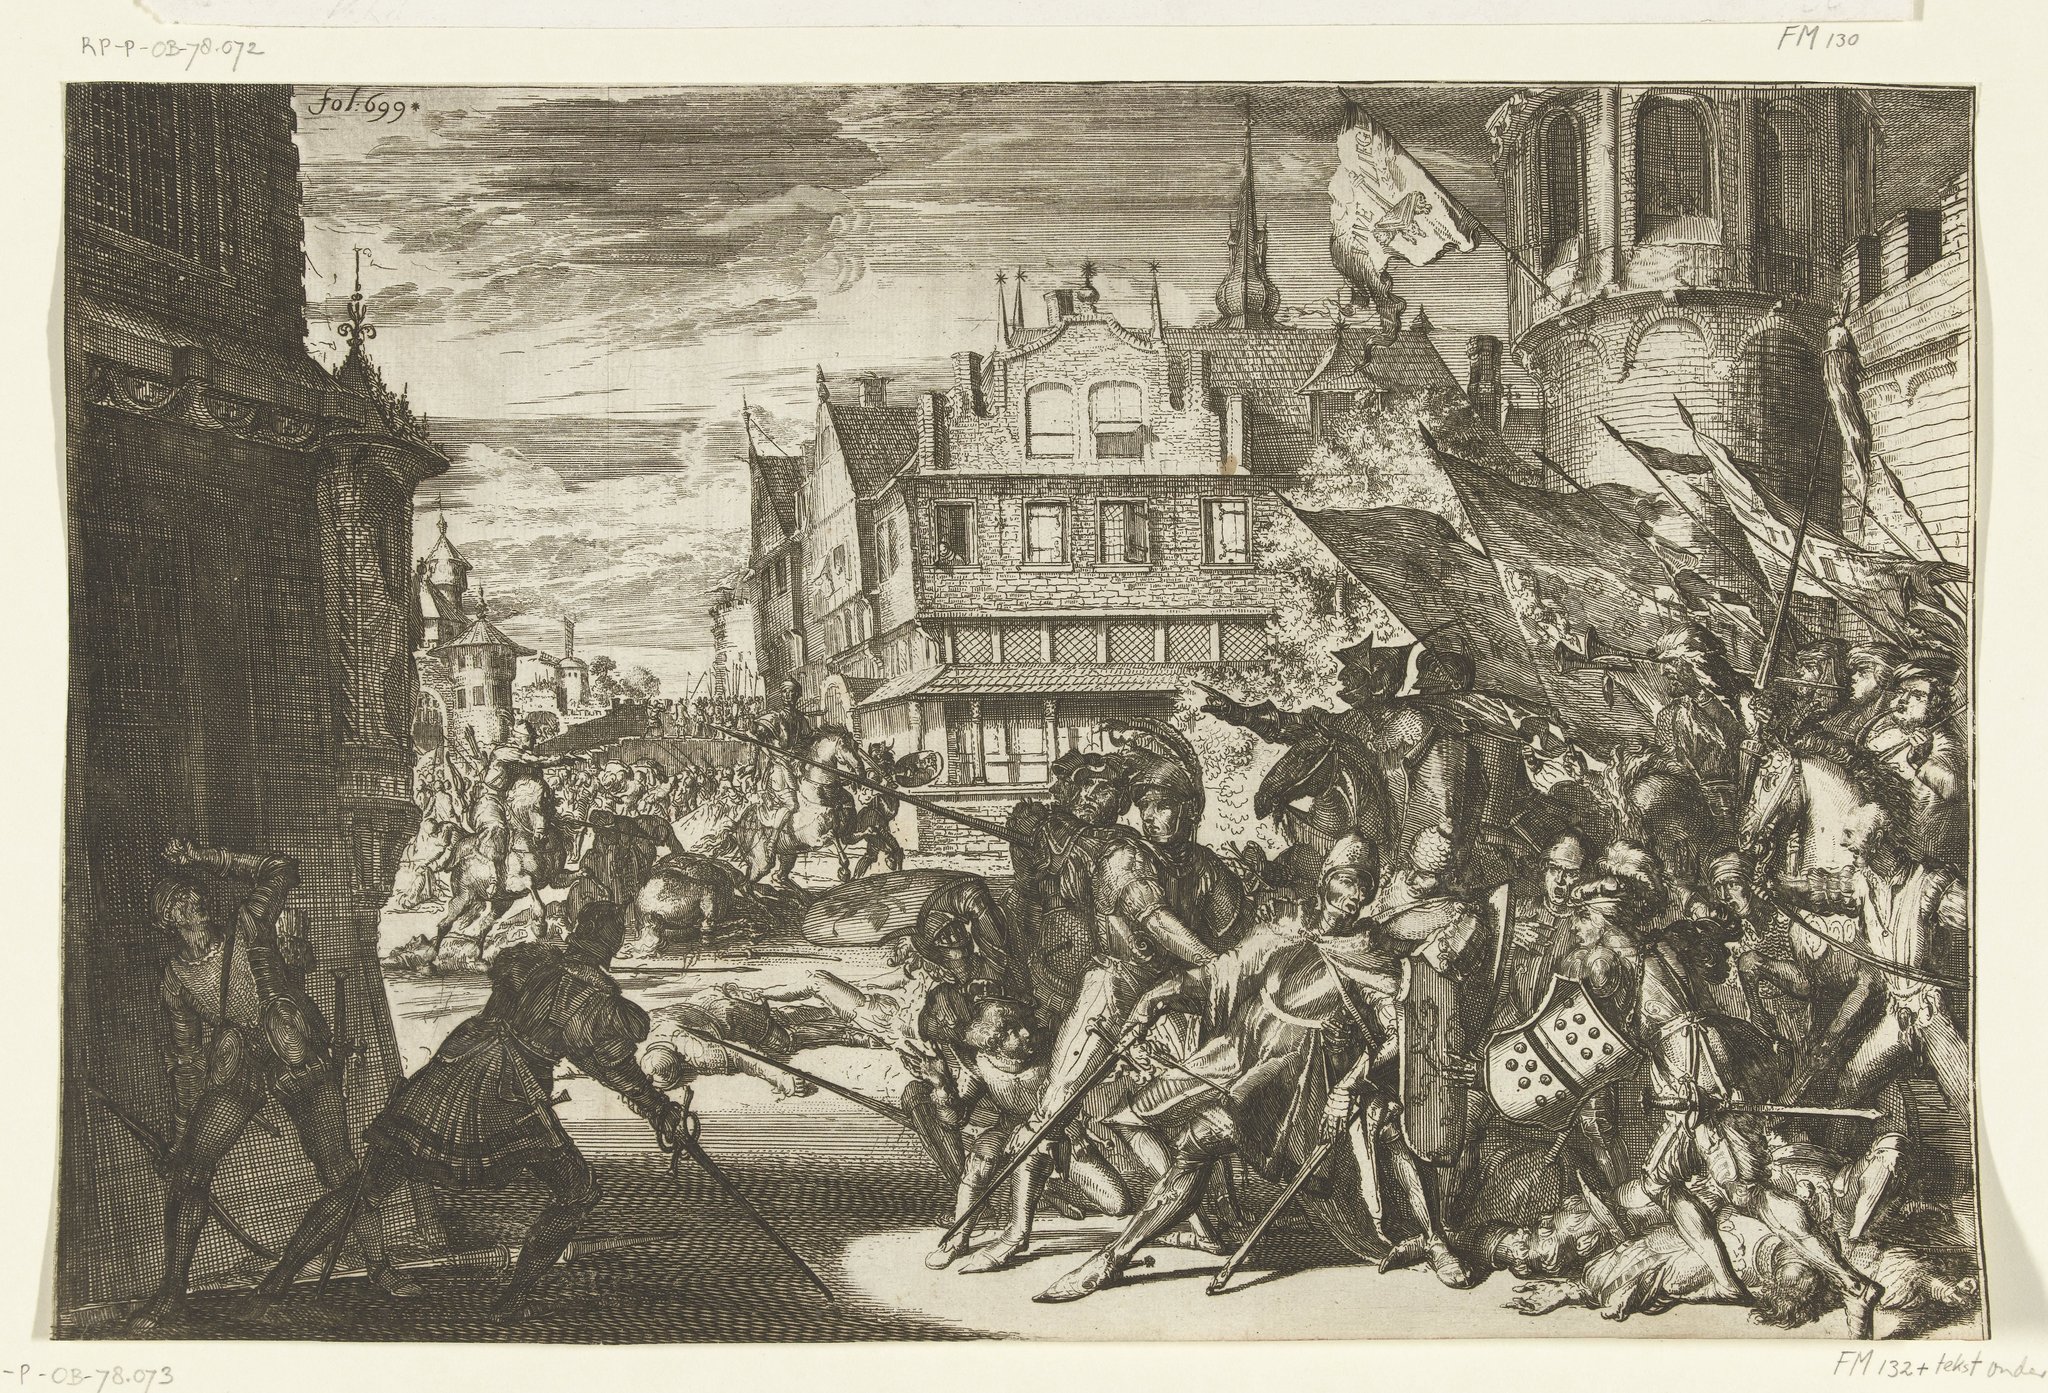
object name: print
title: Dirk IV gedood door een vergiftigde pijl, 1049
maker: romeyn de hooghe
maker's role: draughtsman, goldsmith, painter, print maker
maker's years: 1645-1708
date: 1675-1677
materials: paper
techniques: etching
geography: northern netherlands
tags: battle, fighting in general, violent death, being killed; being mishandled and maltreated; seeking death, dordrecht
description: Graaf Dirk IV wordt in de val gelokt en gedood door een vergiftigde pijl tijdens een gevecht te Dordrecht (of Vlaardingen) op 14 januari 1049. In het midden onderaan zakt Dirk IV te midden van zijn soldaten ineen. In de straten van de stad wordt gevochten.